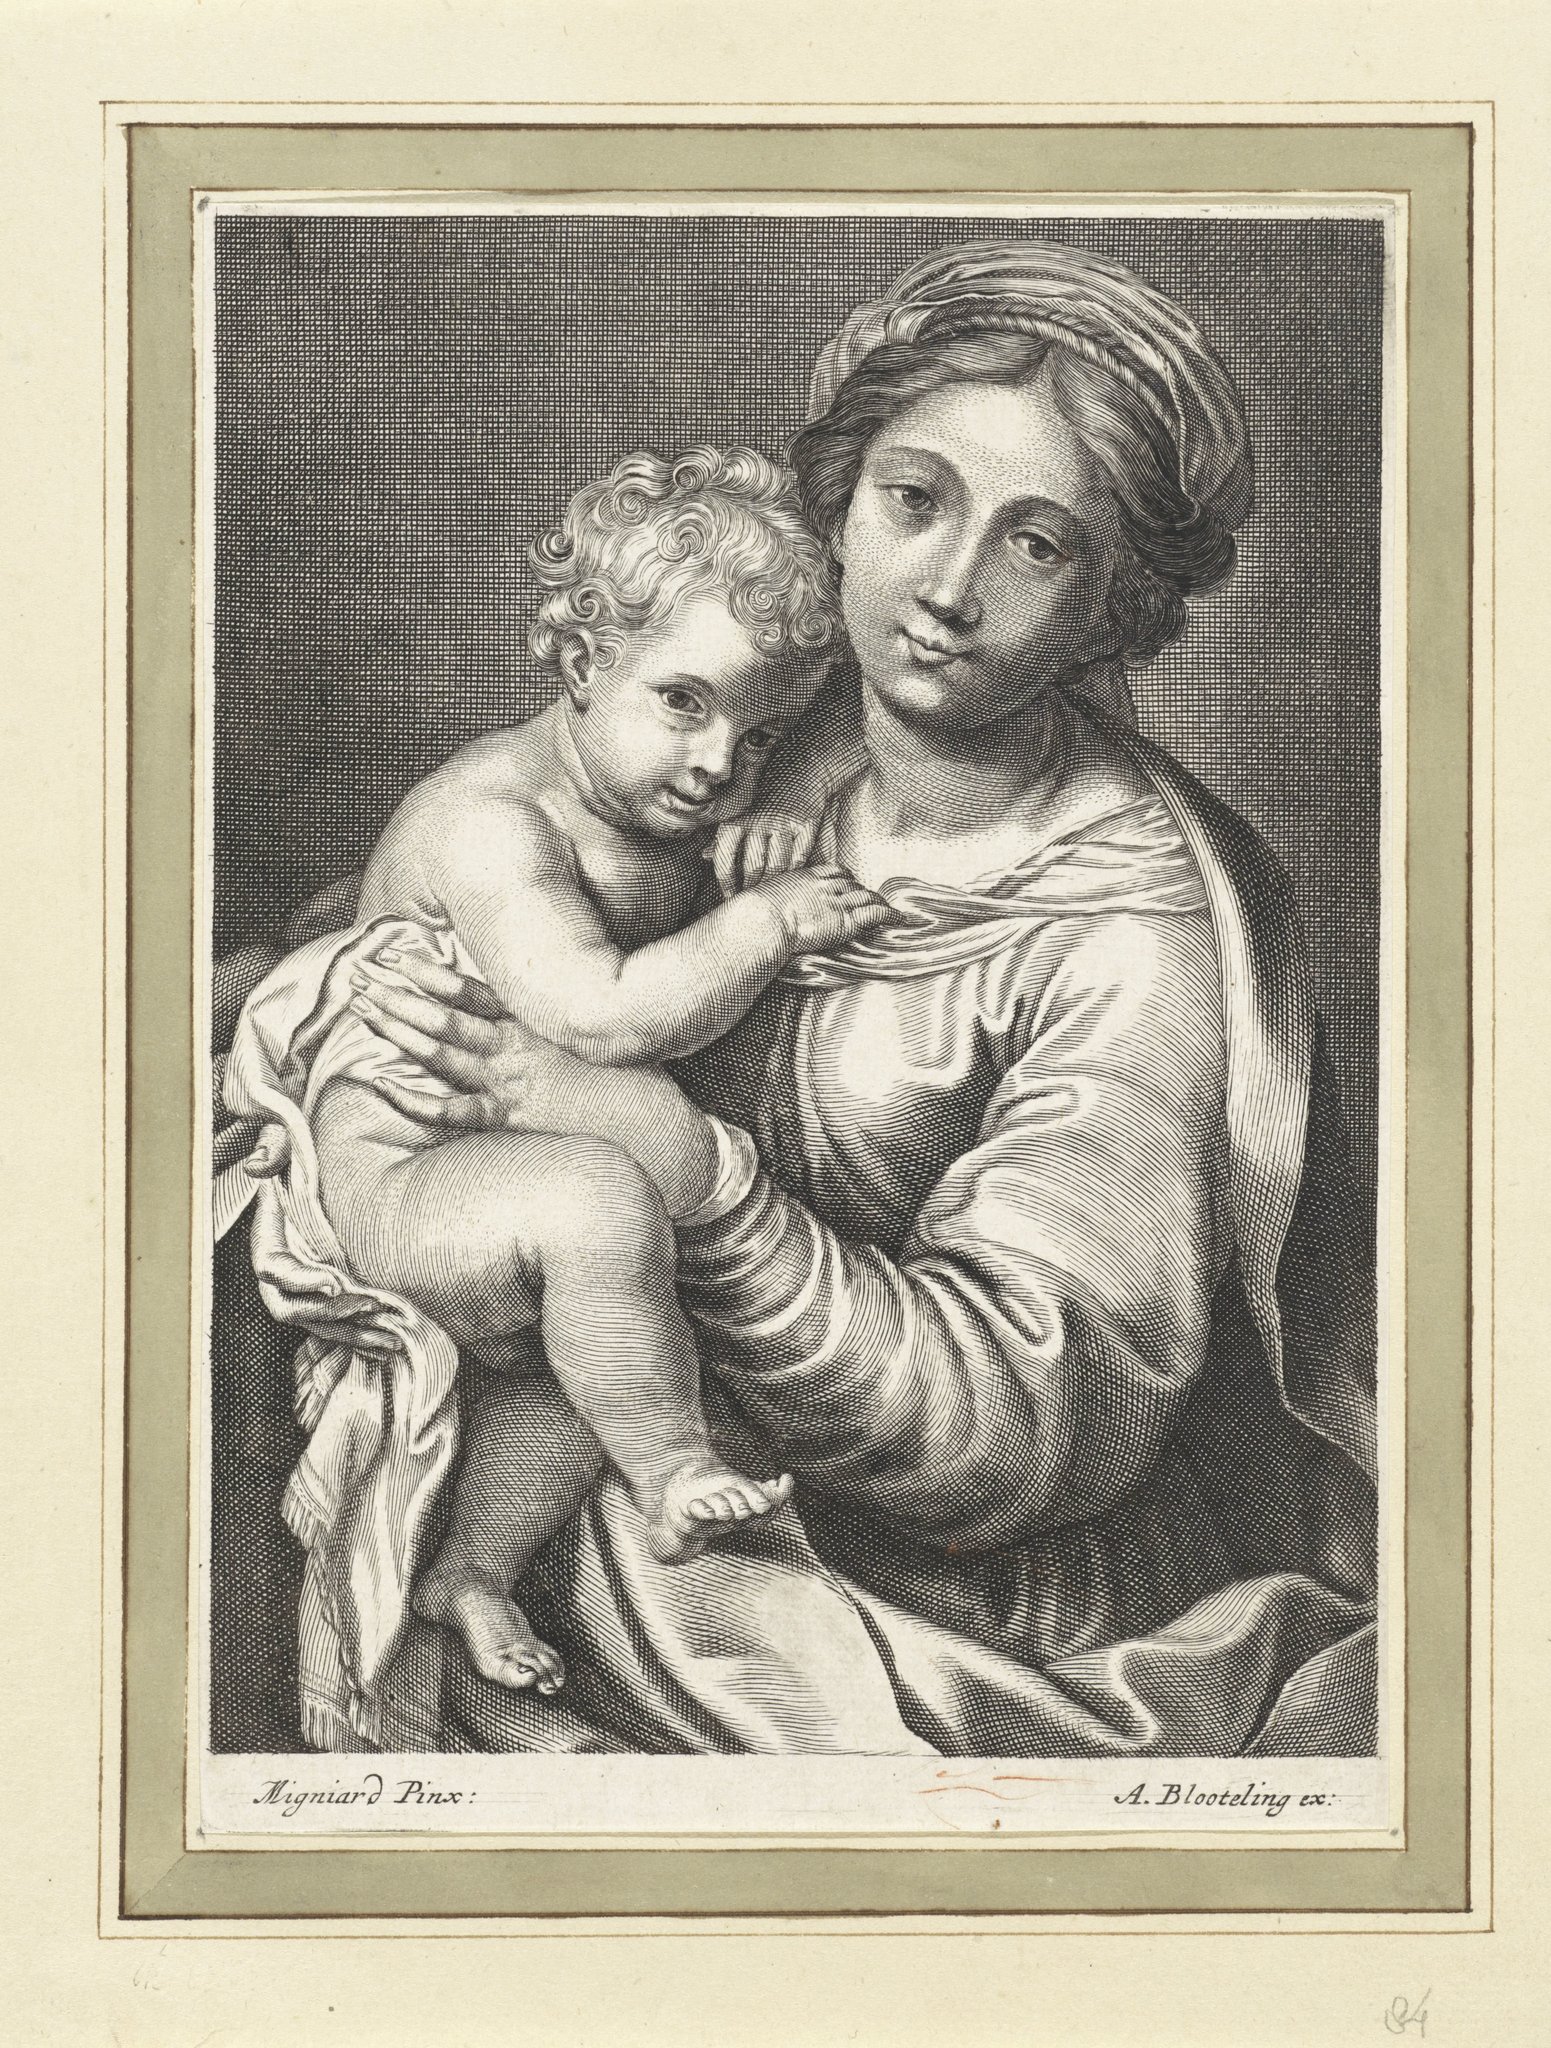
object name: print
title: Maria met kind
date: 1655-1690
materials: paper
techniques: engraving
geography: low countries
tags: madonna: i.e. mary with the christ-child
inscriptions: collector's mark: Lugt 240